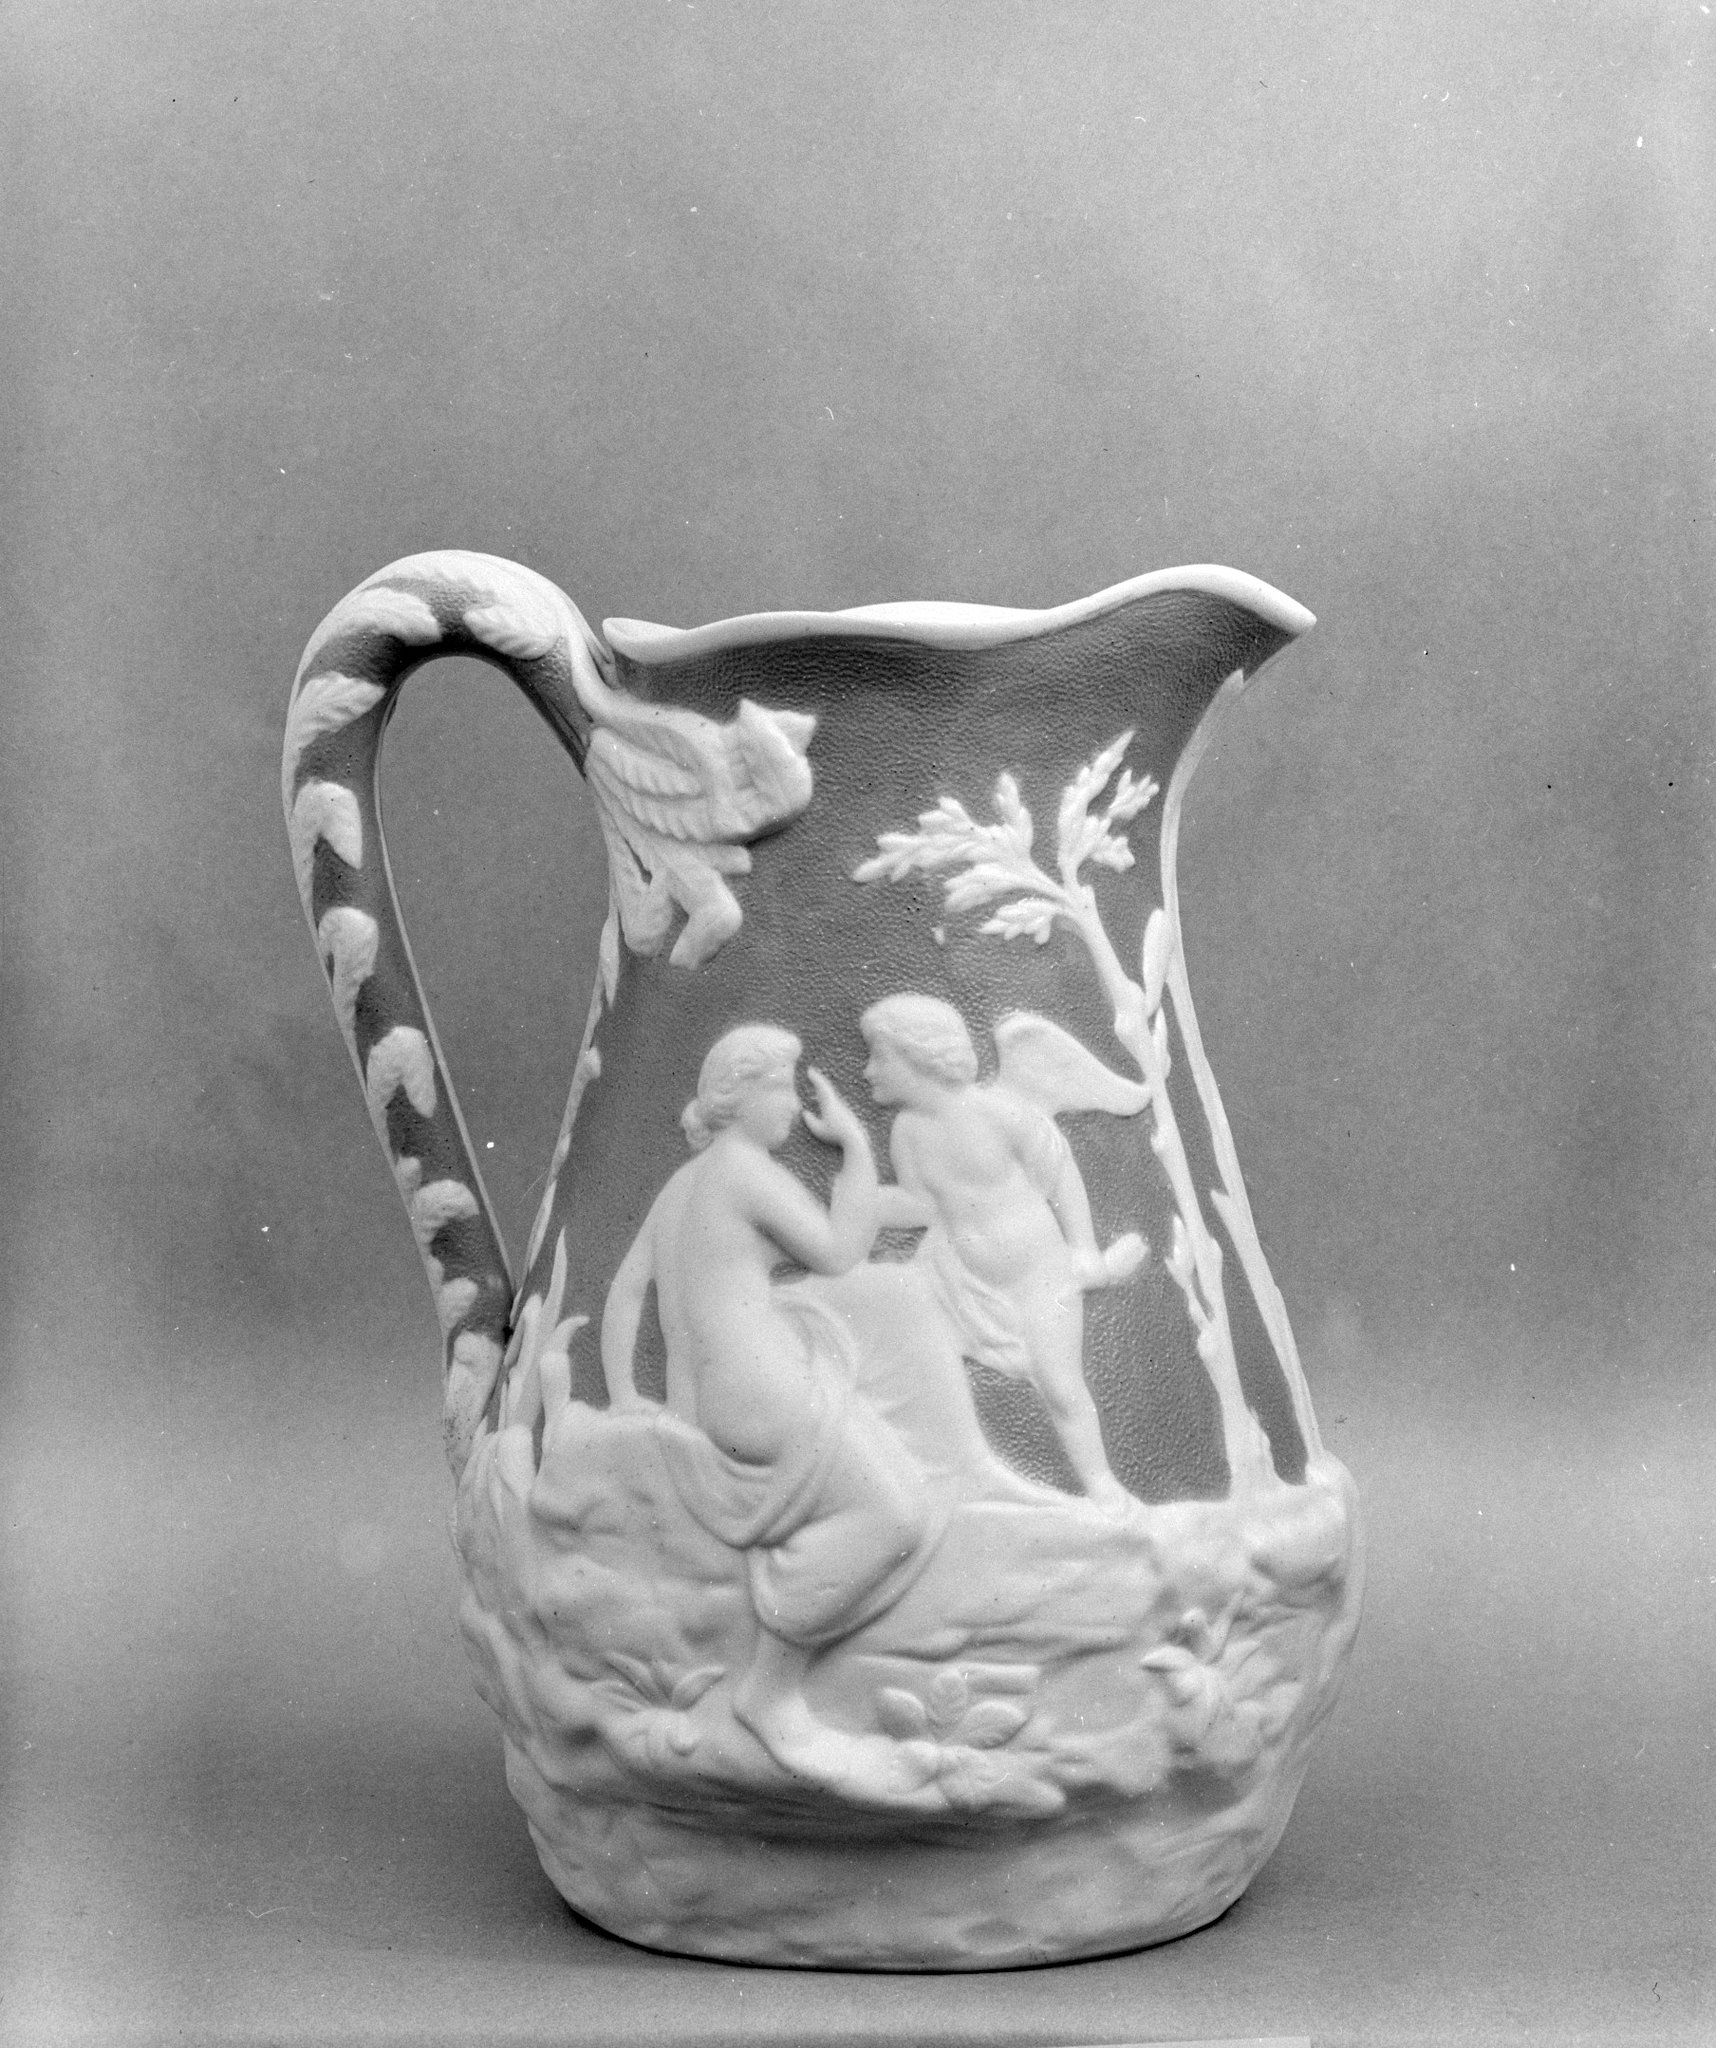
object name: pitcher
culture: american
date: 1830-1870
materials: porcelain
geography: united states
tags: cupid,psyche